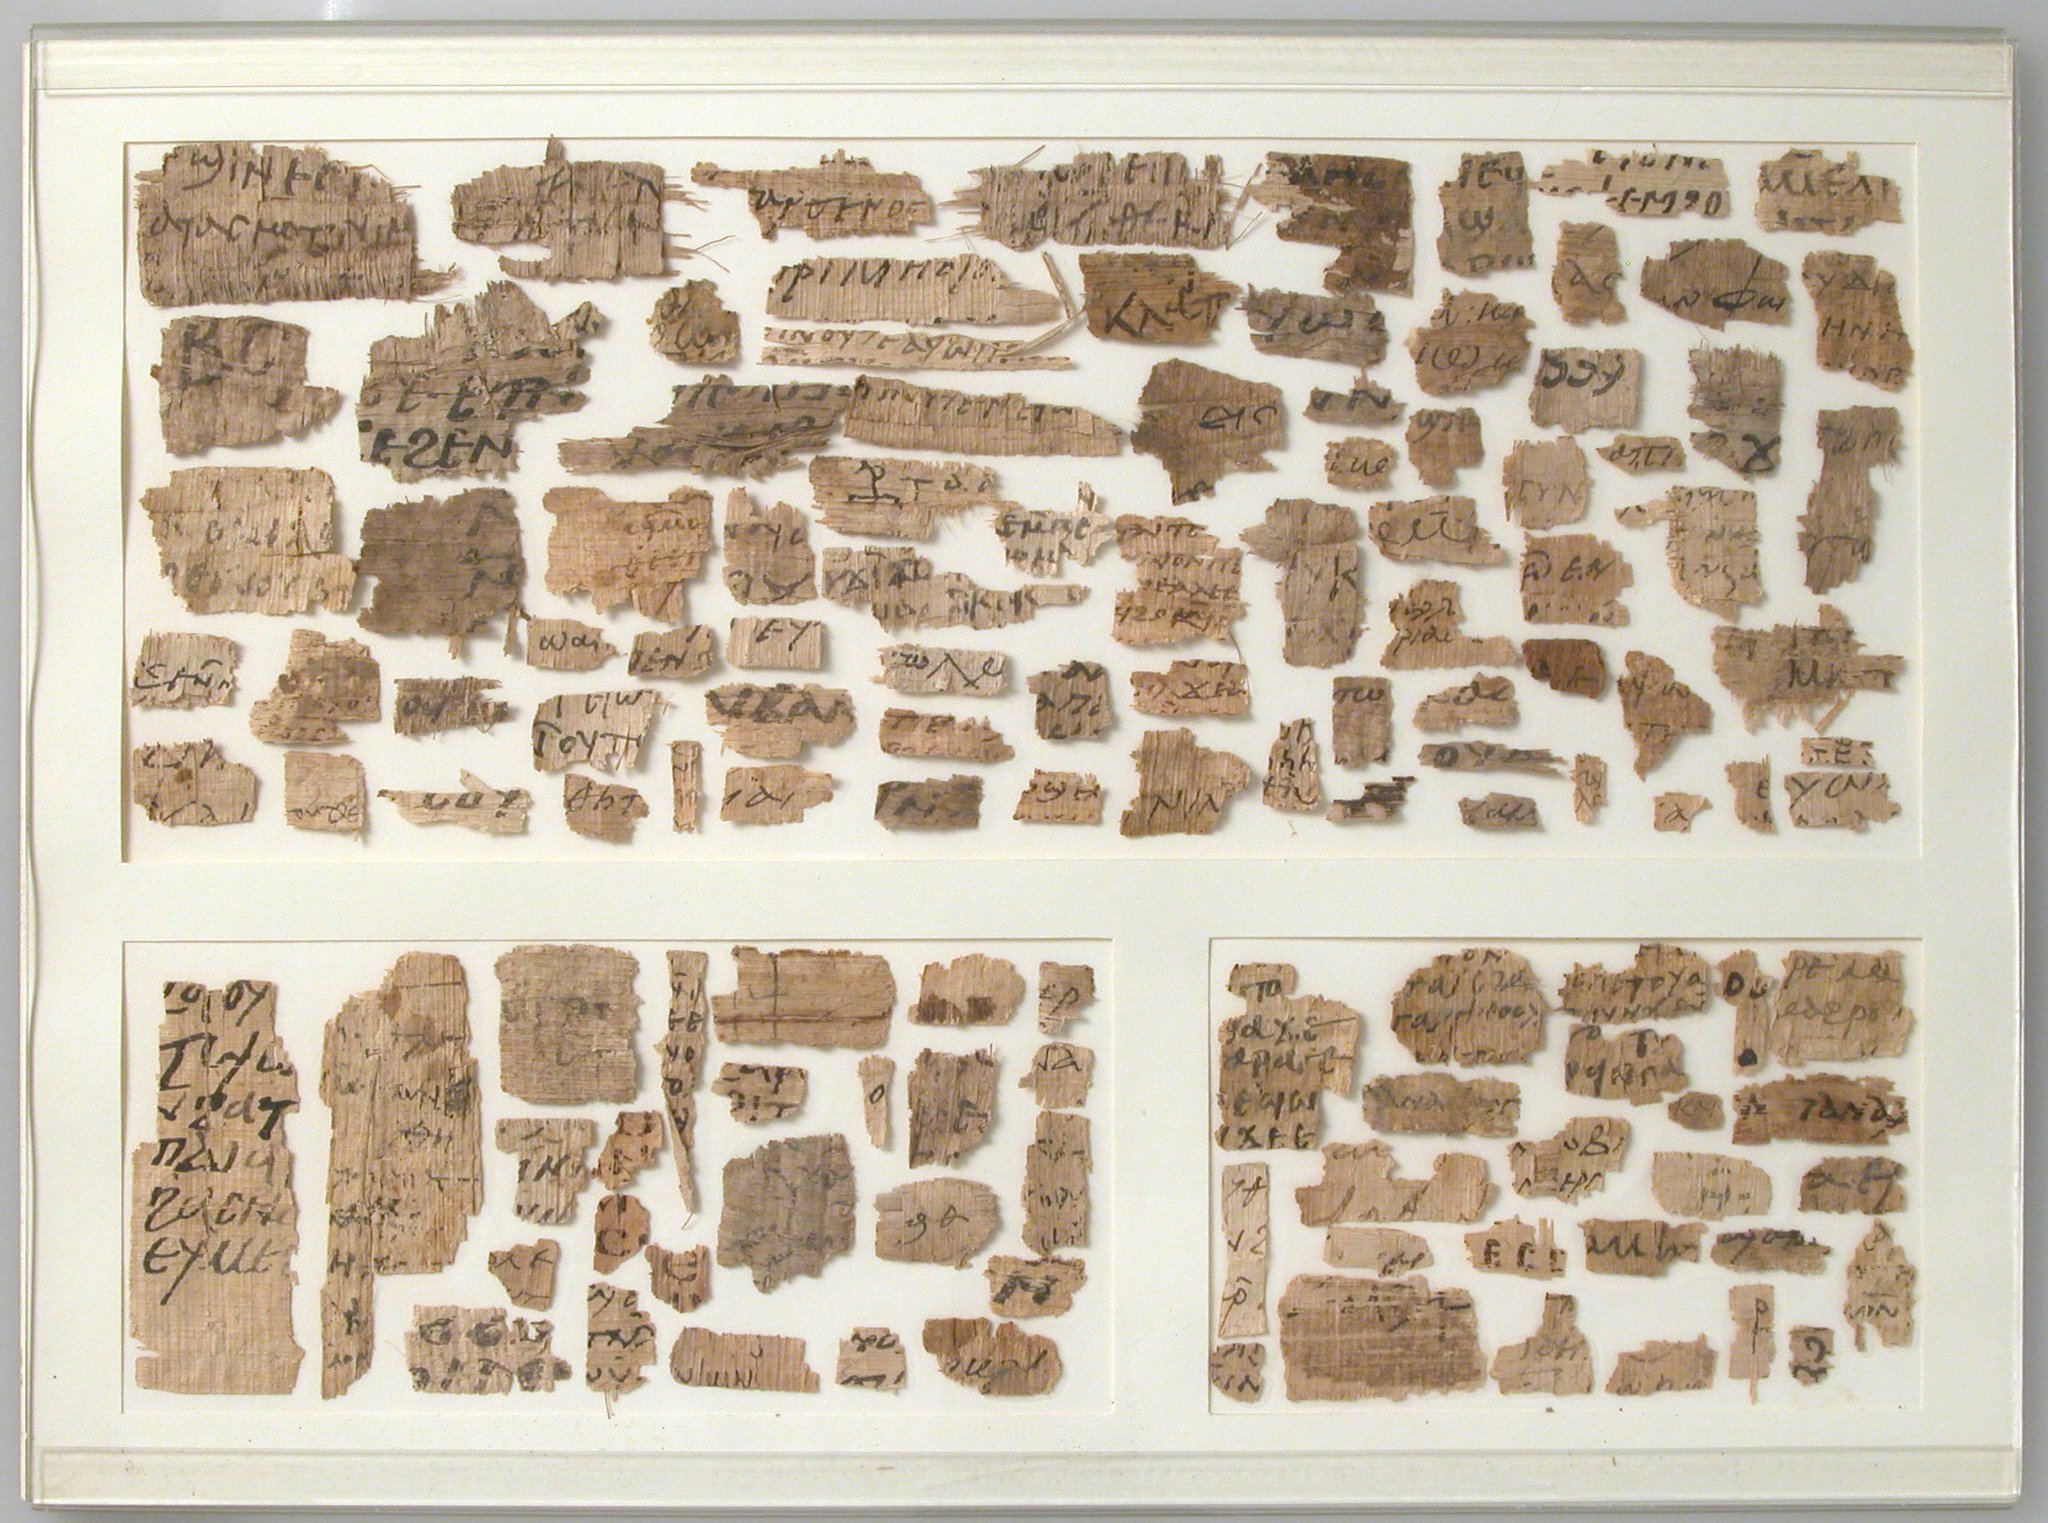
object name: fragment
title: Papyri Fragments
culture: coptic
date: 601-700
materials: ink, papyrus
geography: egypt